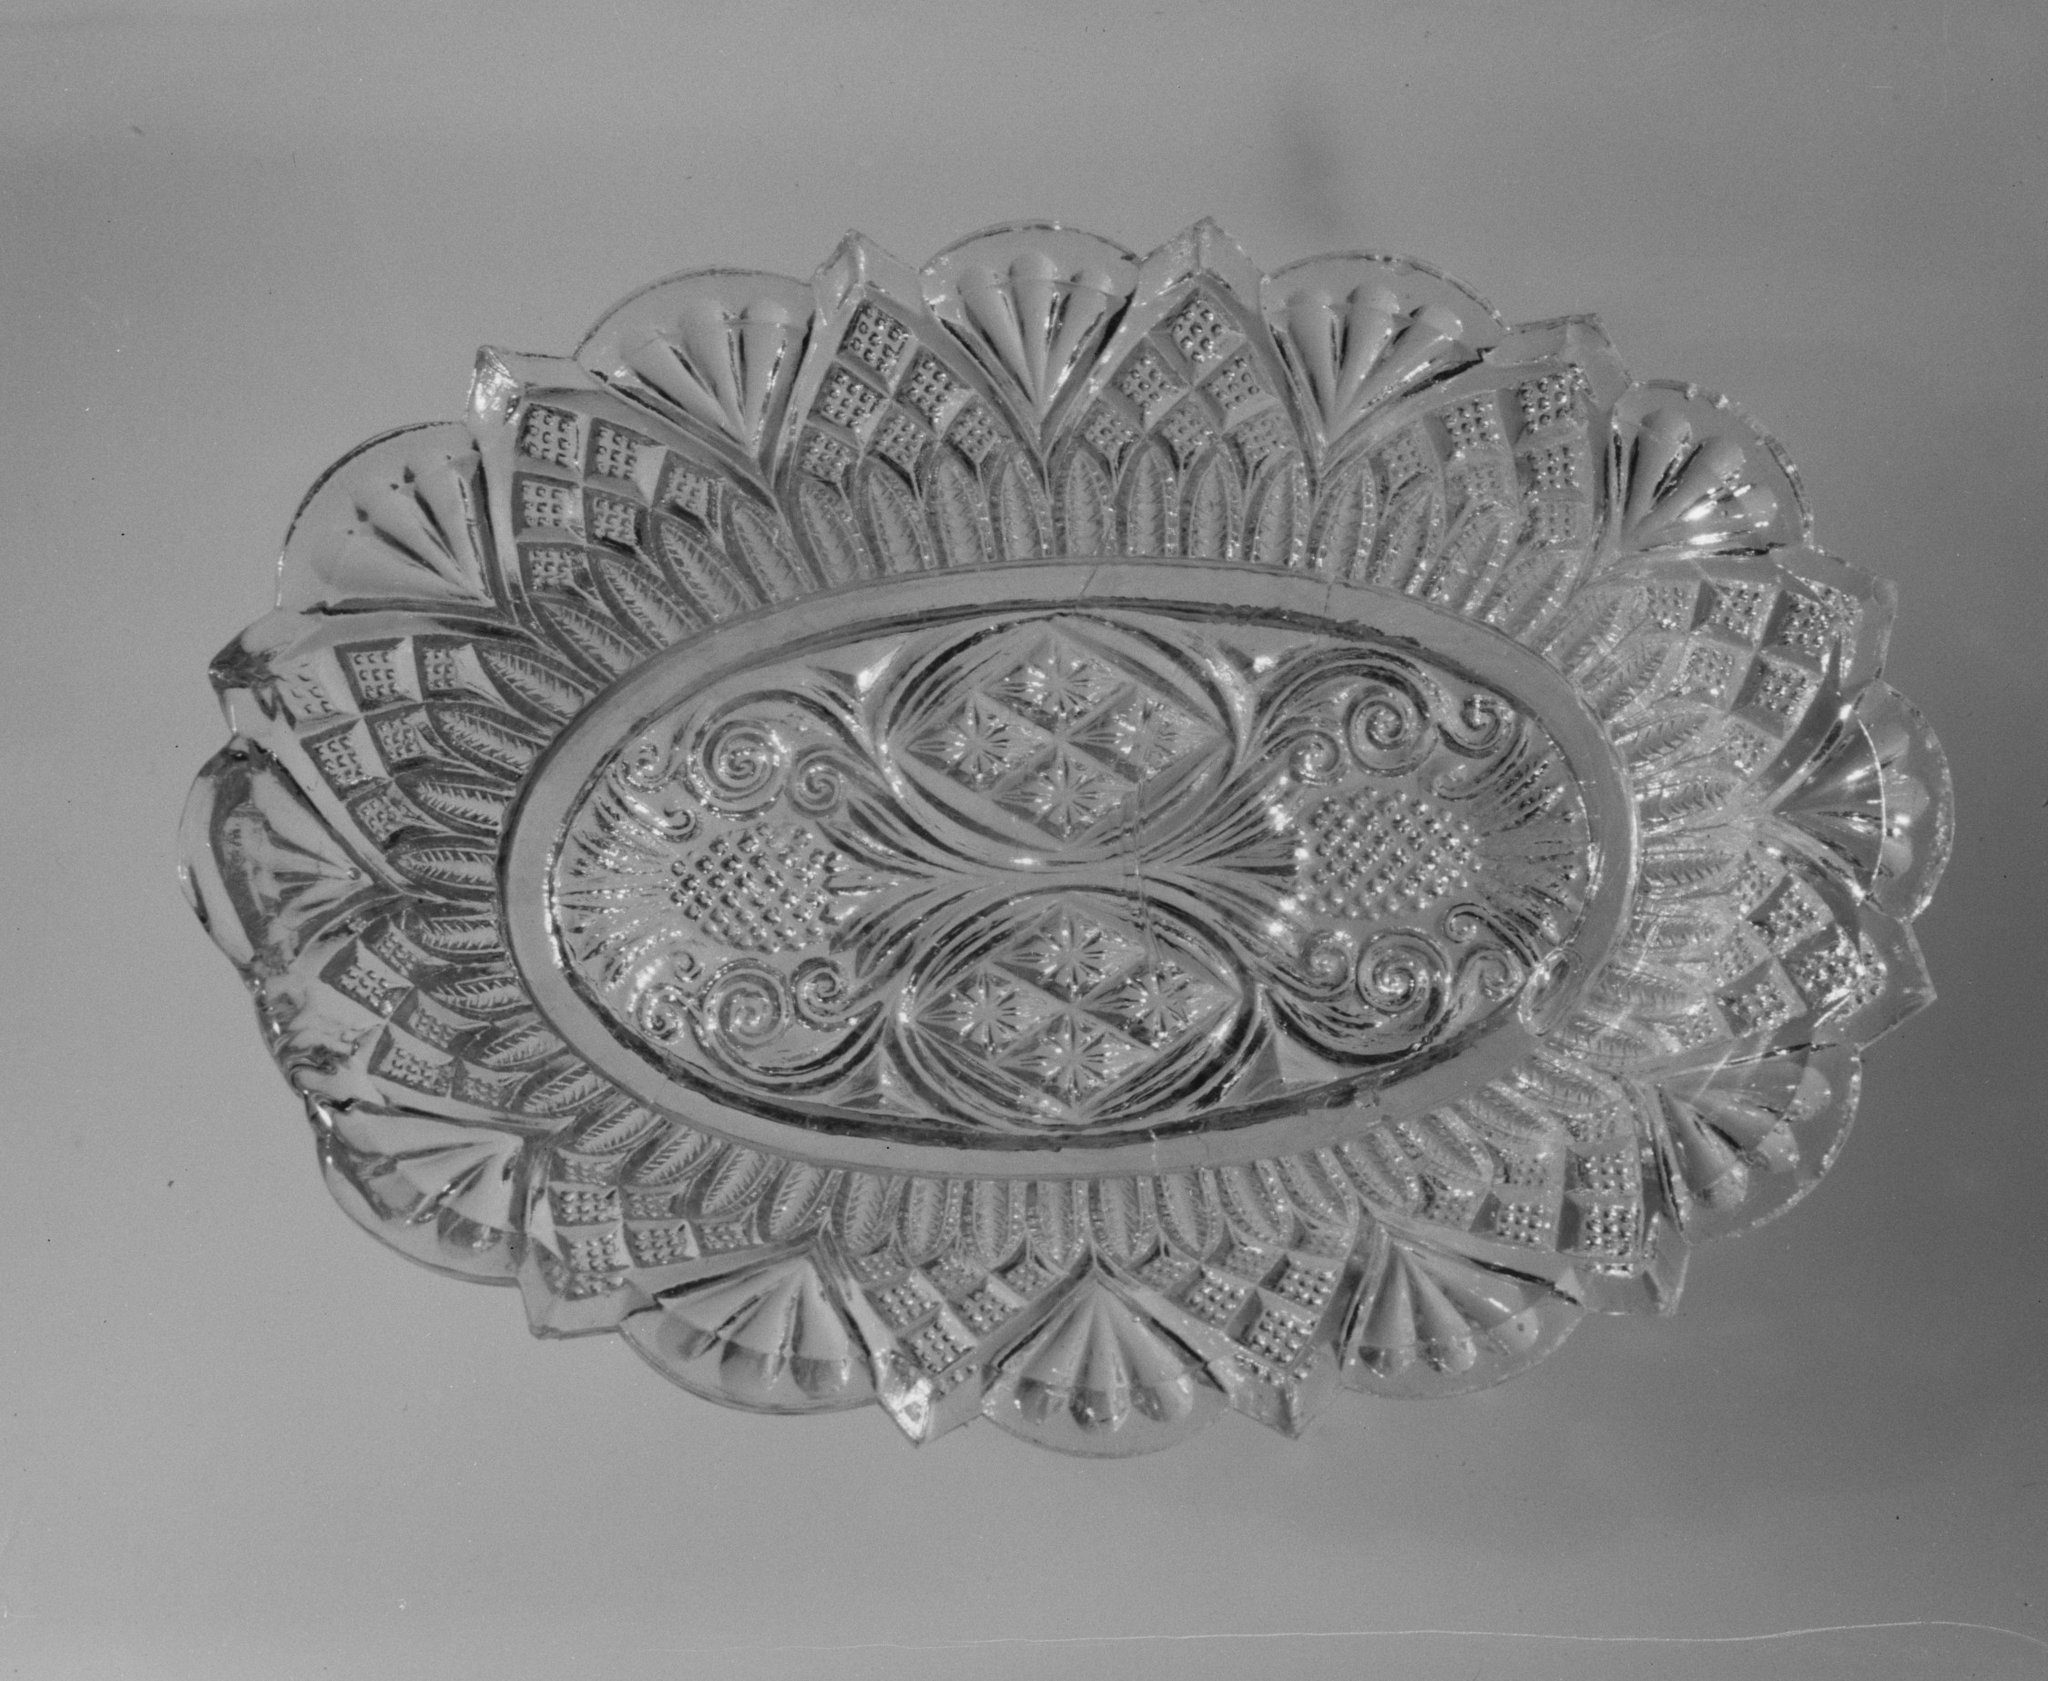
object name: dish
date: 1800-1900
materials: glass